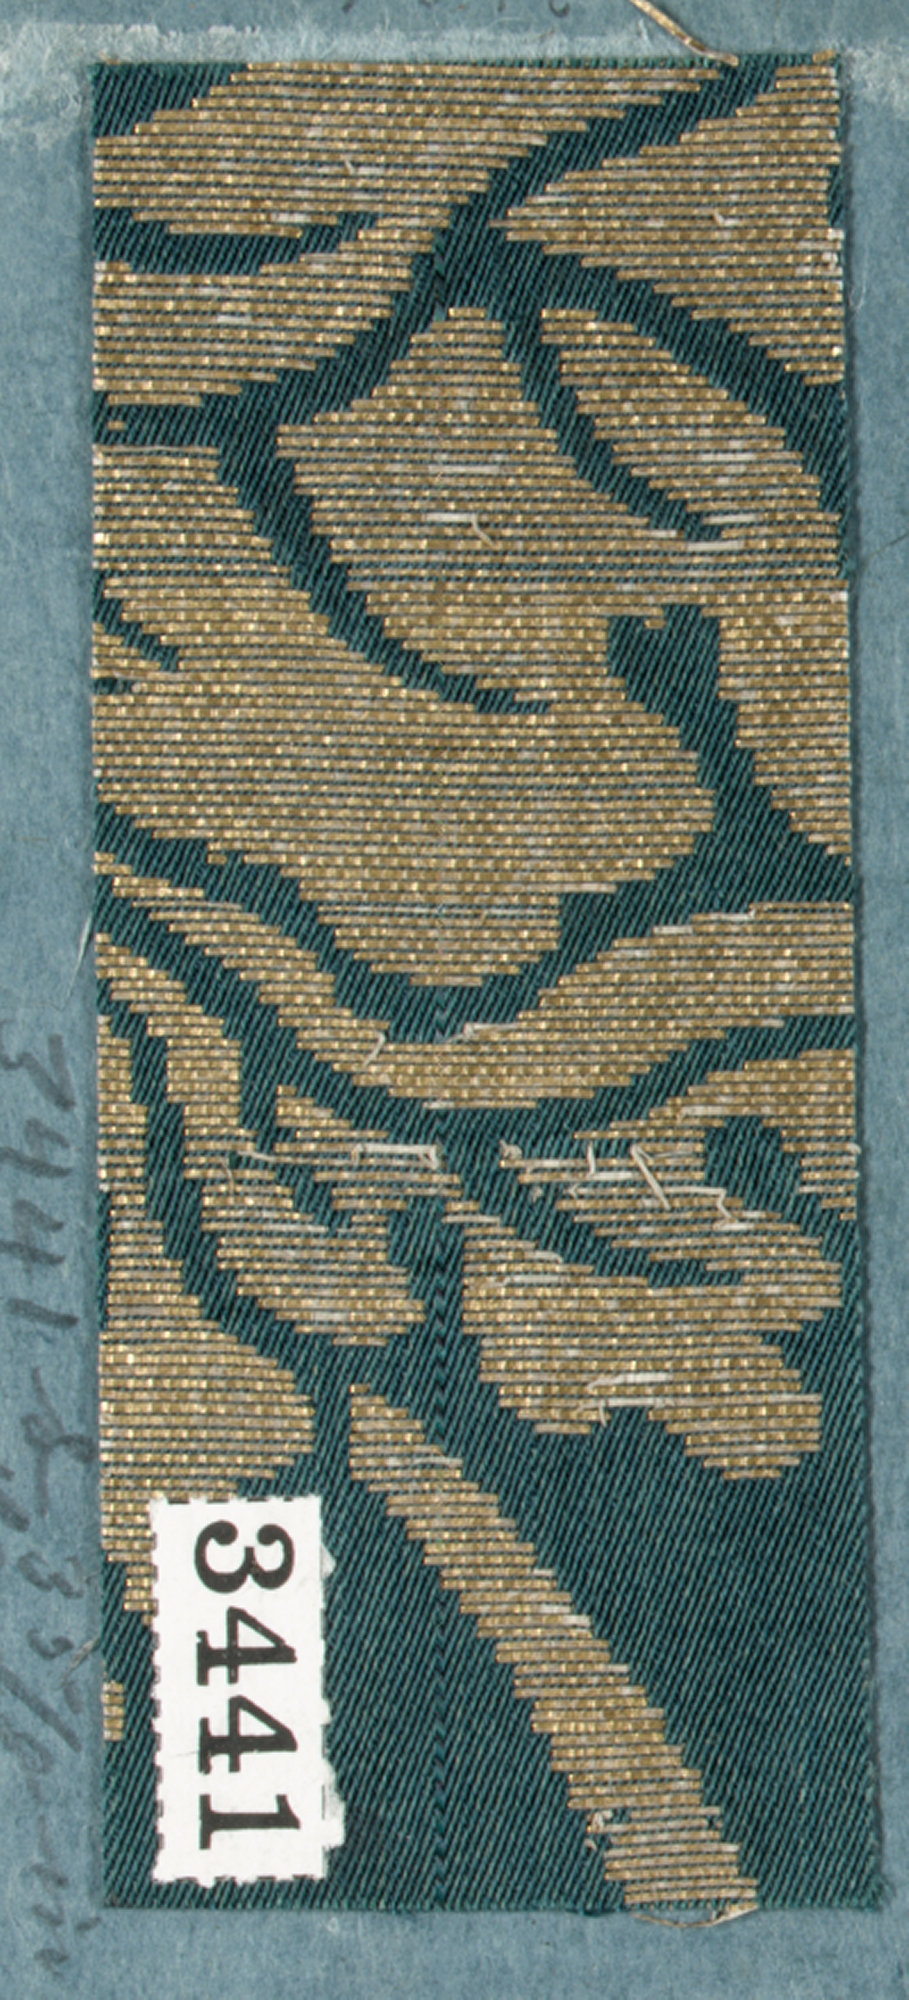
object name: textile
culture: japanese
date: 1801-1900